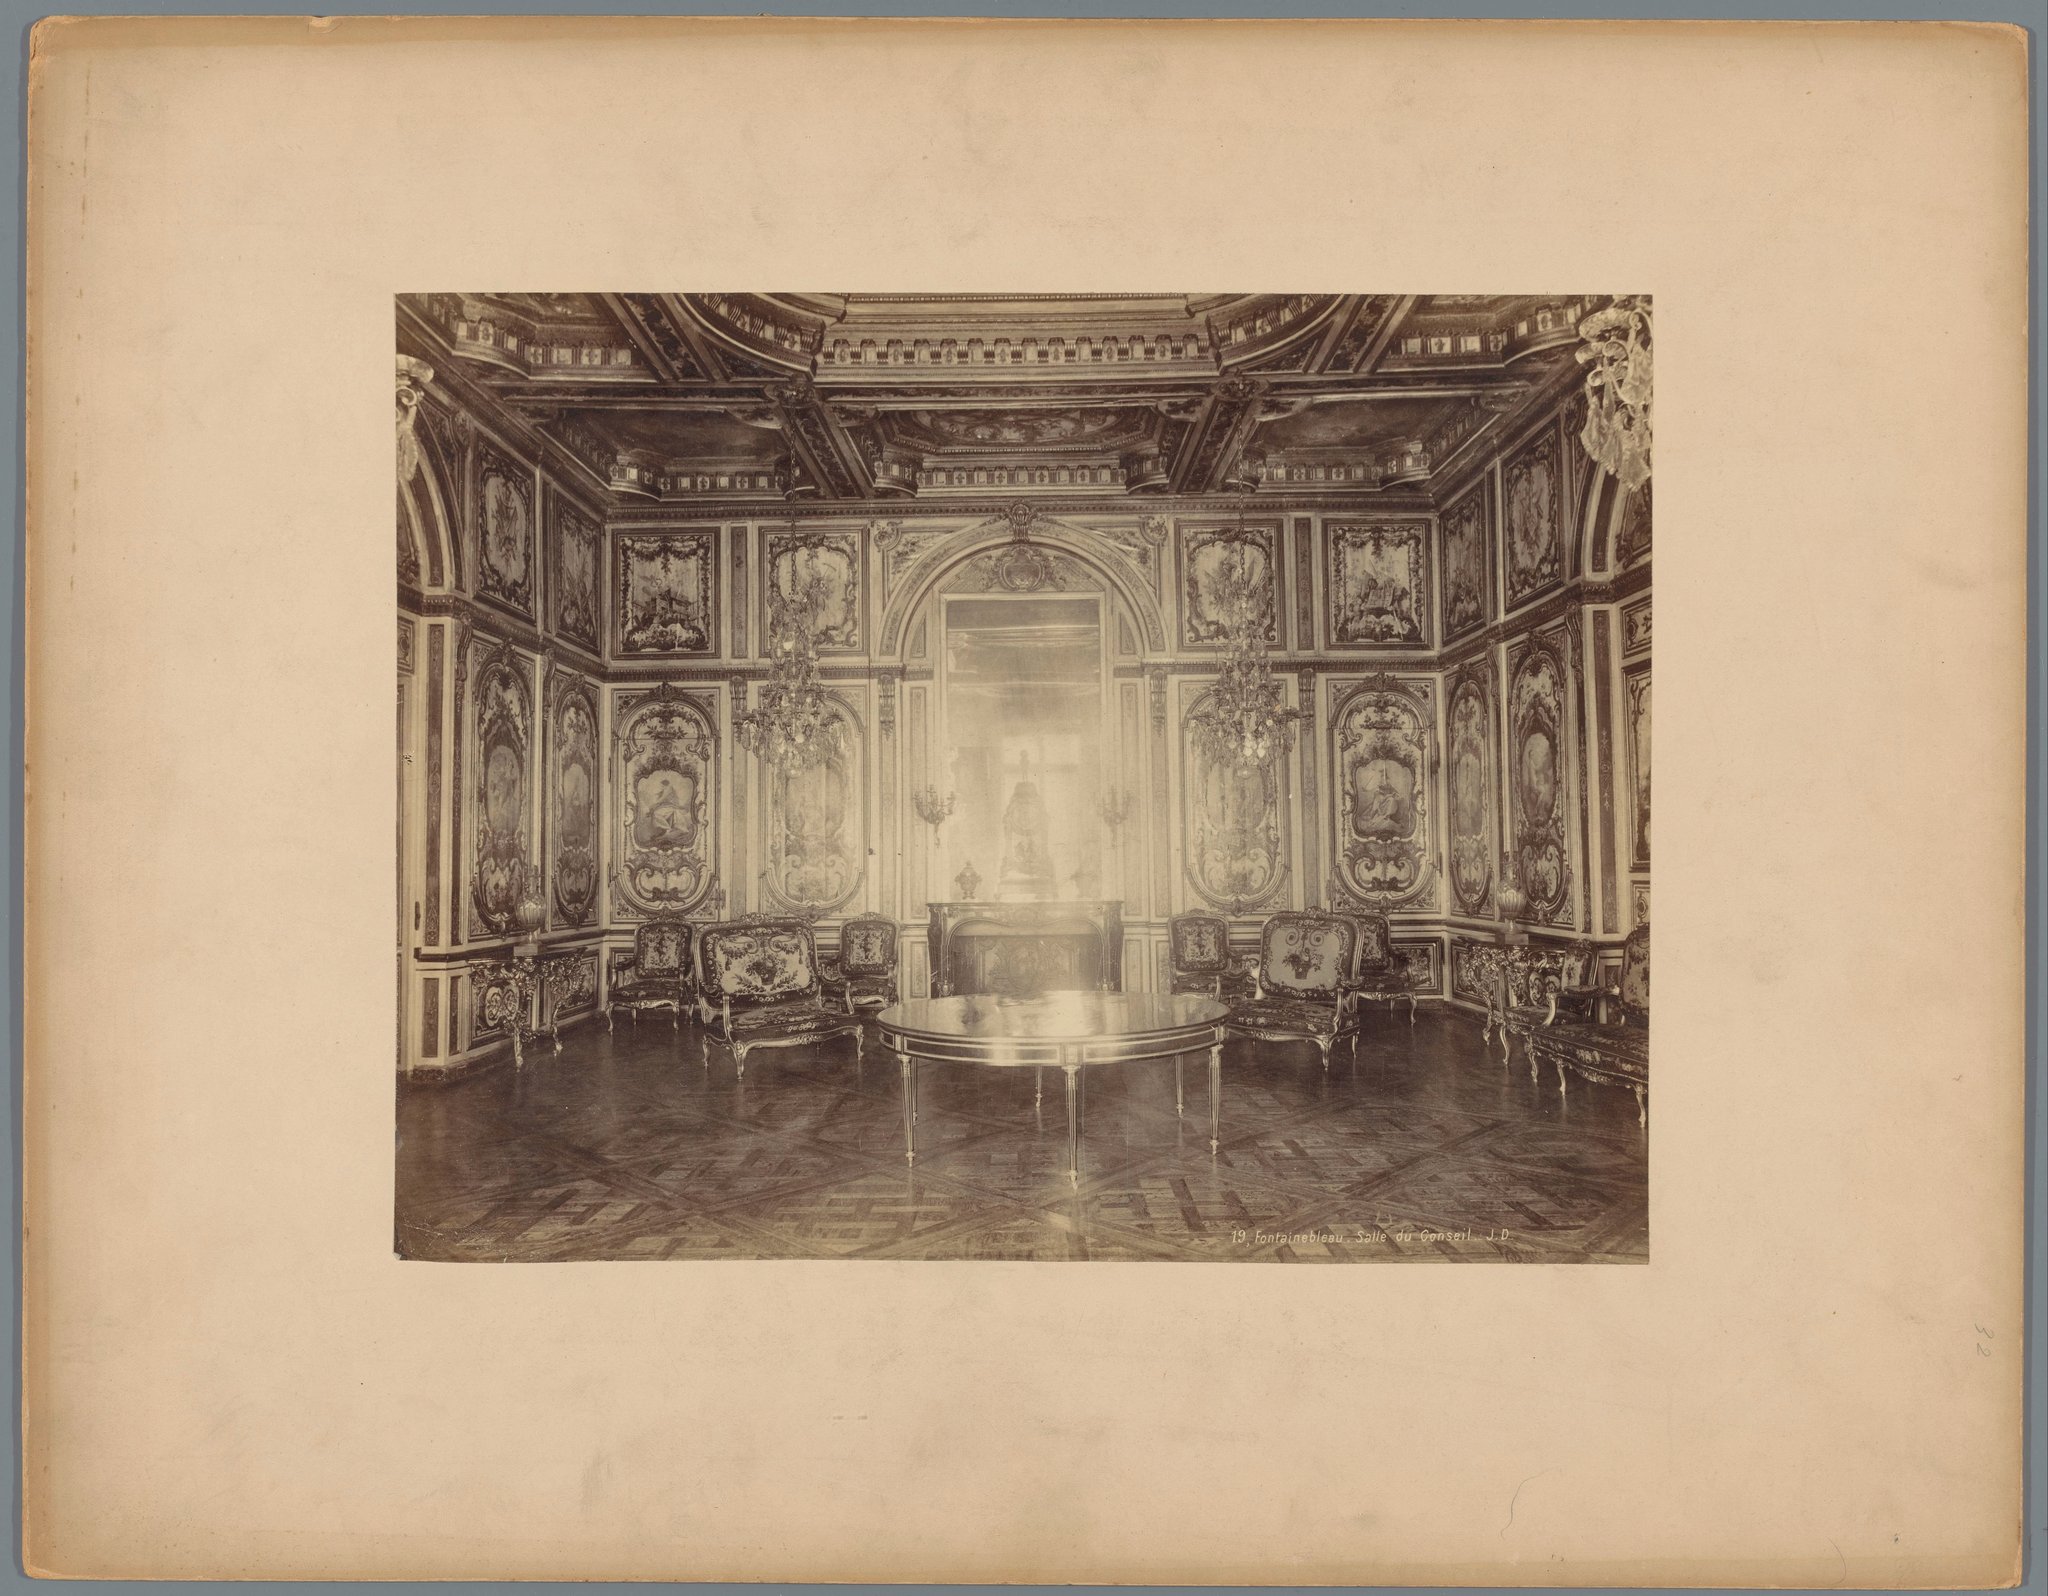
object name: photograph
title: Interieur van de raadzaal in het Paleis van Fontainebleau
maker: Anonymous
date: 1875-1900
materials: cardboard, photographic support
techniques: albumen print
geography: fontainebleau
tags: seating furniture, mirror, palace, interior ~ representation of a building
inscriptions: number: ‘19,’, collector's mark: Lugt 3937, inscription: ‘J.D.’